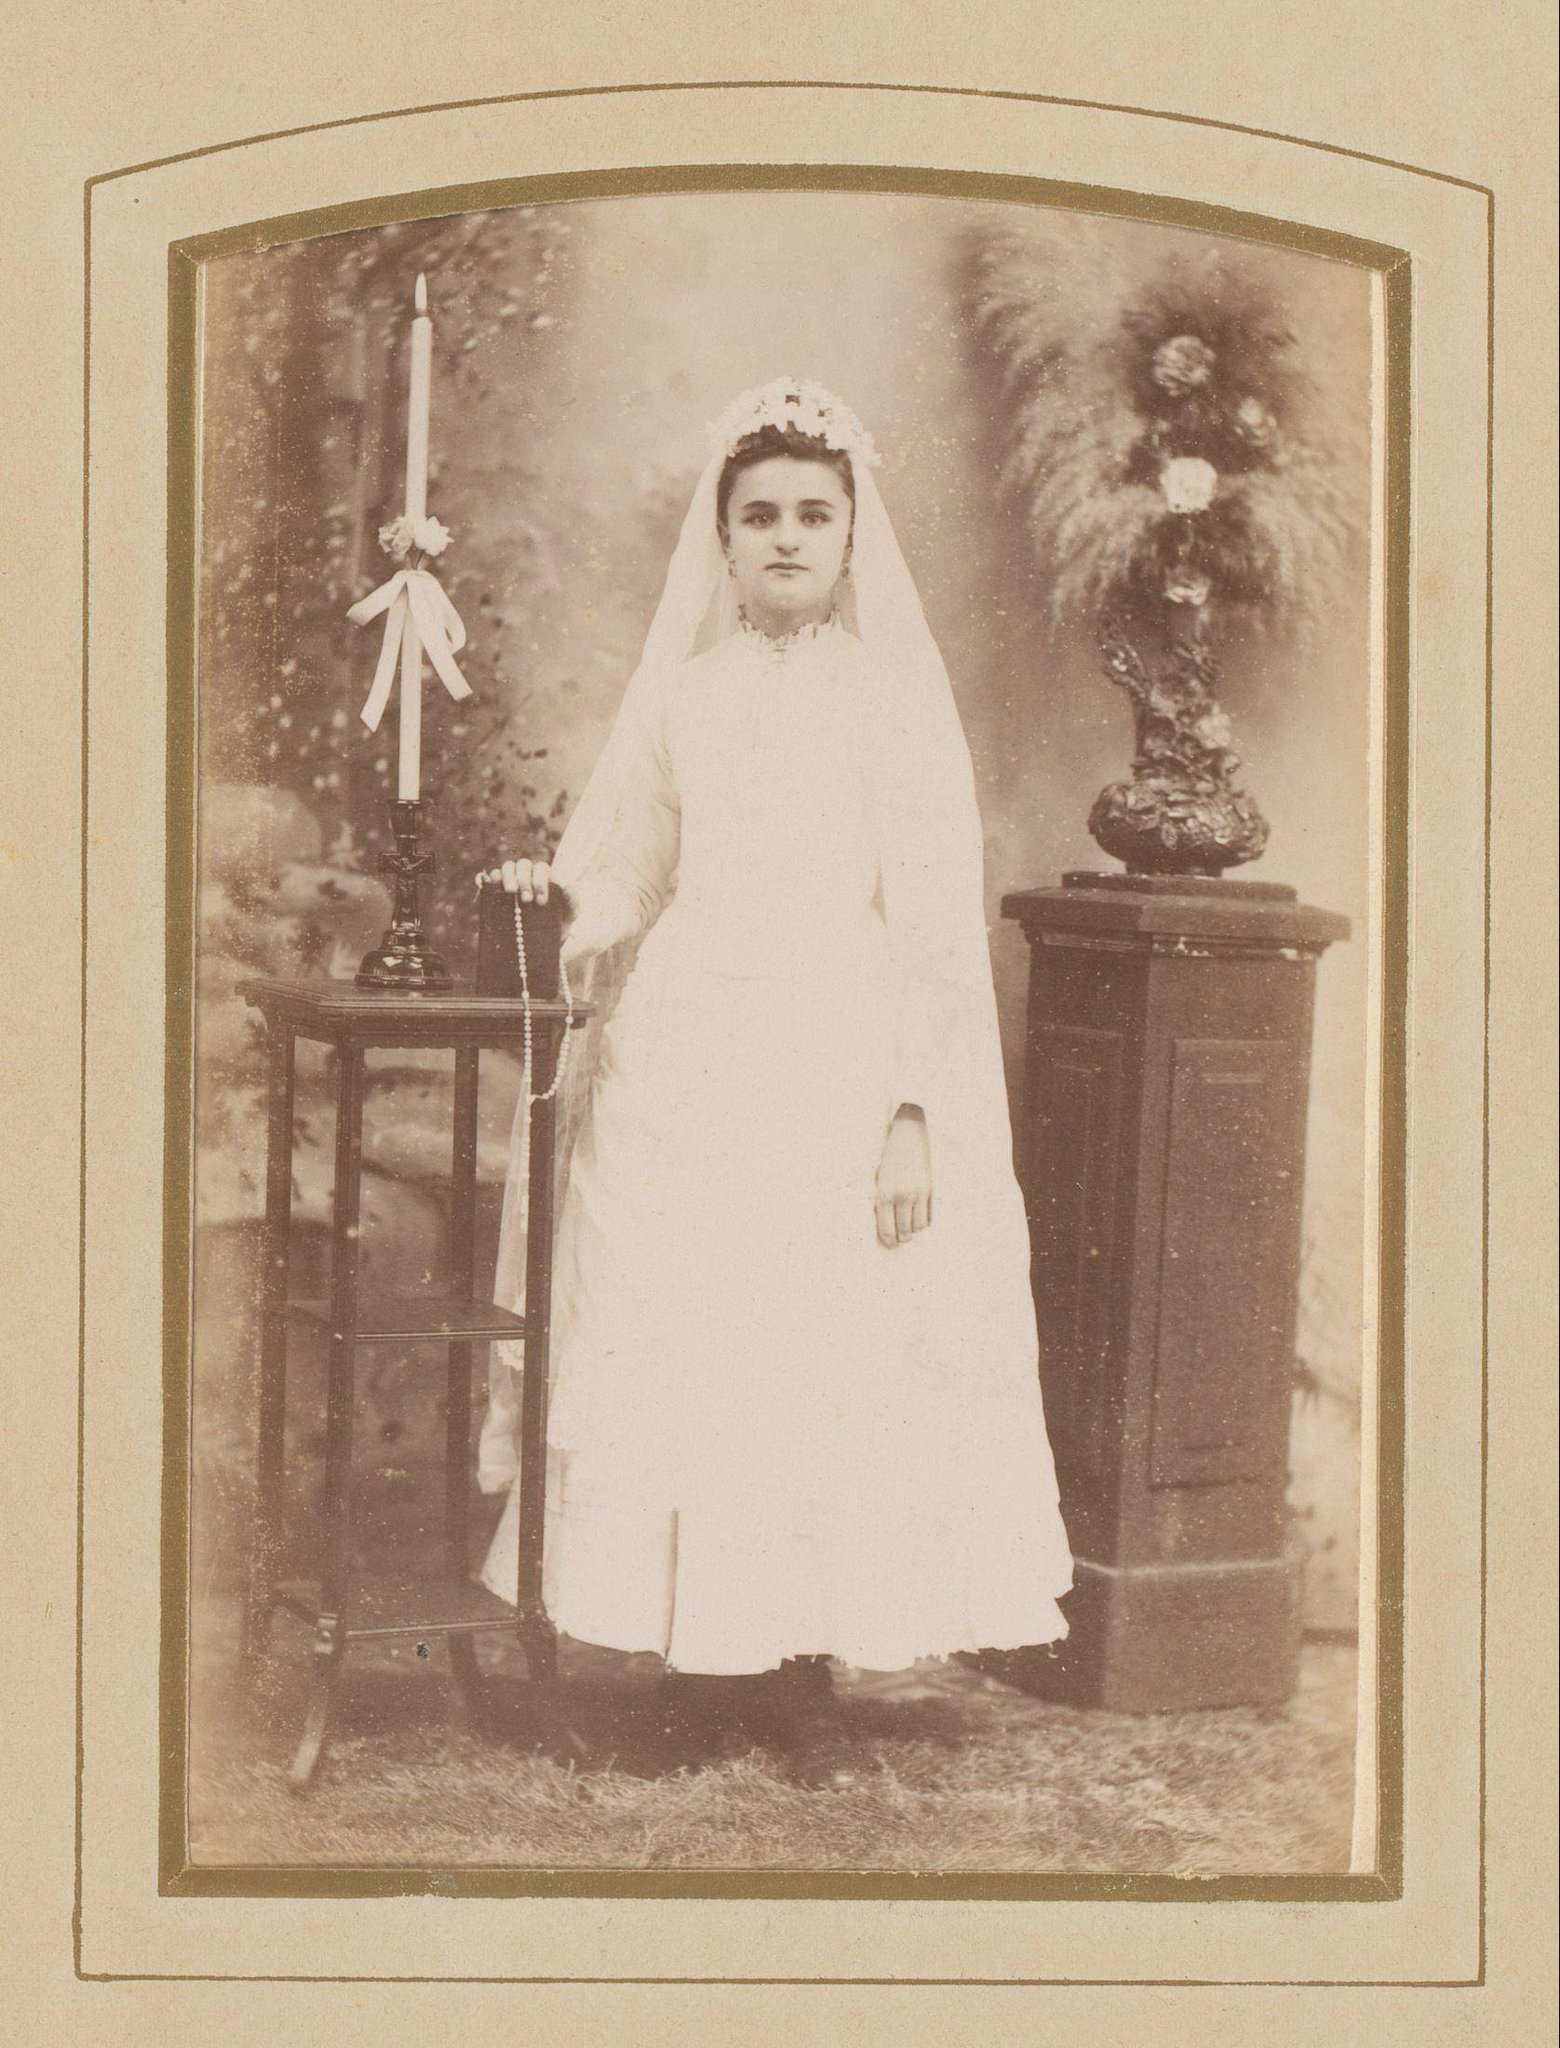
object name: cabinet photograph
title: Portret van meisje in communiejurk, aangeduid als Bertha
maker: christ bannhard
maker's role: fotograaf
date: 1870-1900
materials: cardboard, photographic support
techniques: albumen print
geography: bremen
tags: communion dress, girl (child between toddler and youth)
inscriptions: inscription: ‘Ch. Bannhard/ 650 Milwaukee Ave./ Chicago’, annotation: ‘Bertha’